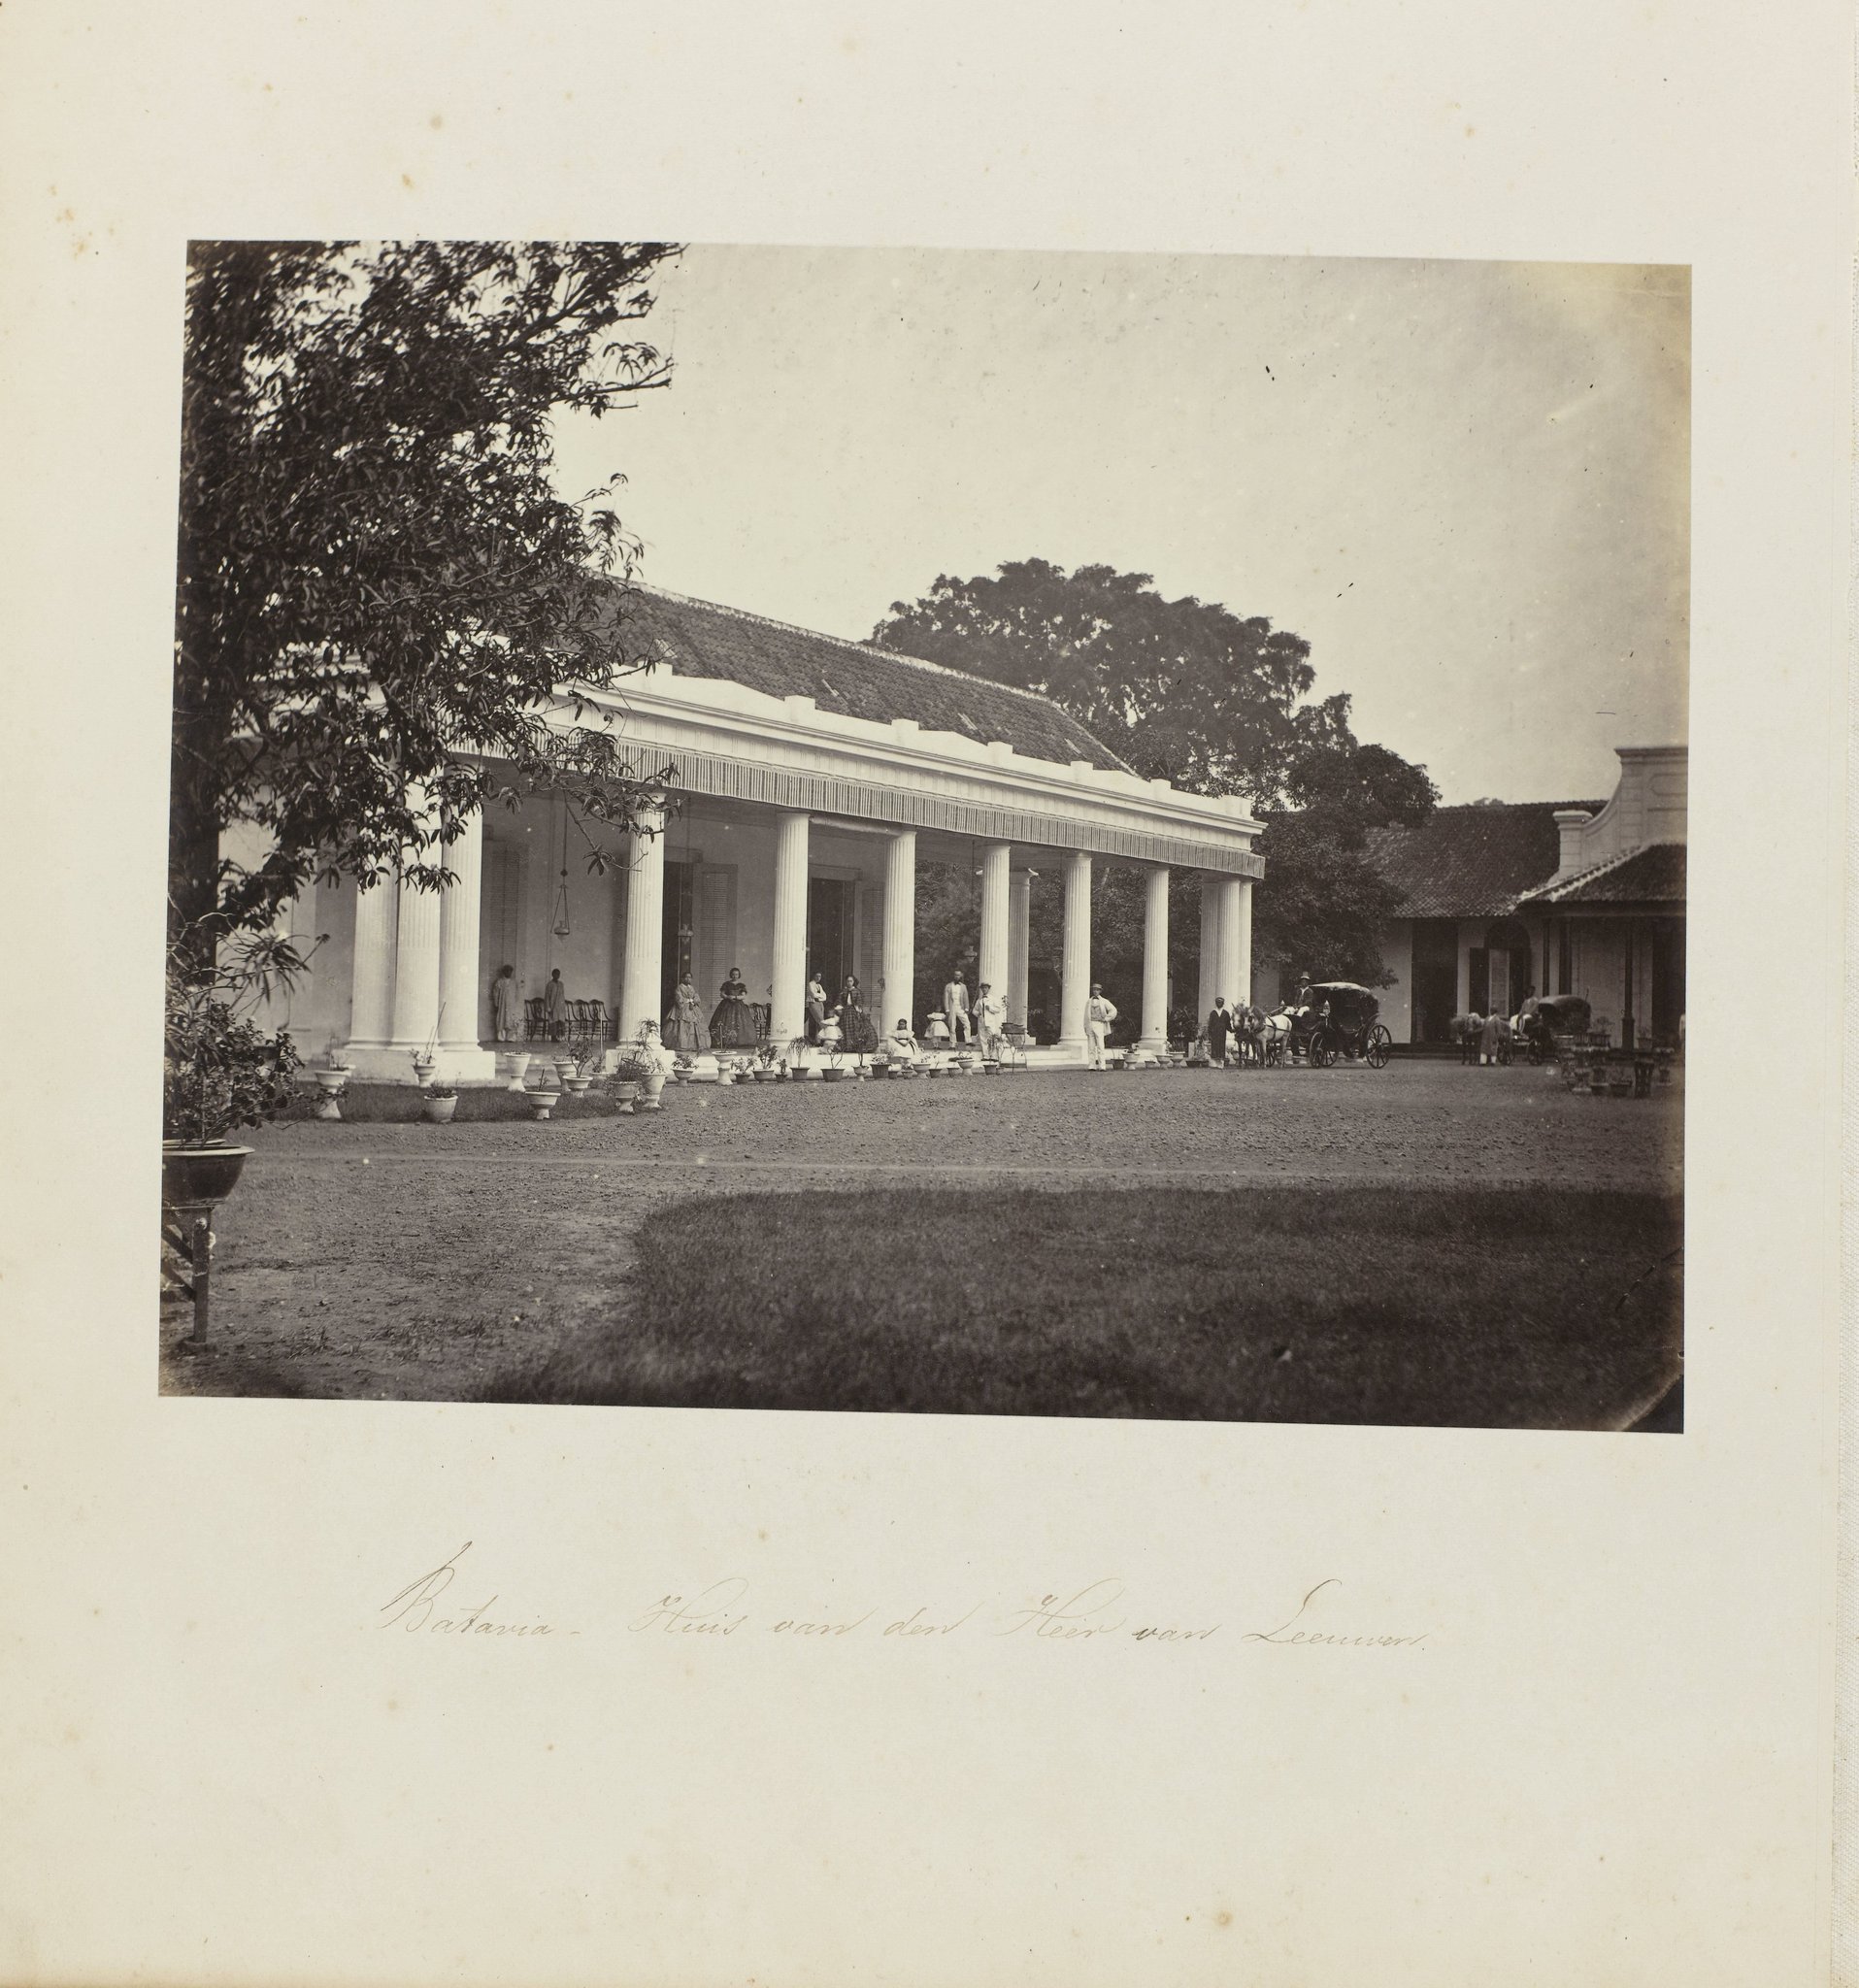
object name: photograph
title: Batavia - Huis van den Heer van Leeuwen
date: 1863-1866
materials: photographic support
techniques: albumen print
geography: batavia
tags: detached house in city, batavia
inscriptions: inscription: ‘Batavia - Huis van den Heer van Leeuwen’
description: Gezicht op huis van de heer Van Leeuwen aan het Molenvliet in Batavia (het huis Moenswijk, later onderdeel van het Hotel des Indes). Eigenaren en personeel poseren op de veranda, rechts enkele rijtuigen. Onderdeel van het rode fotoalbum met foto's van Java, uit het bezit van apotheker Specht-Grijp, die in 1865 vanuit Batavia naar Nederland terugkeerde.